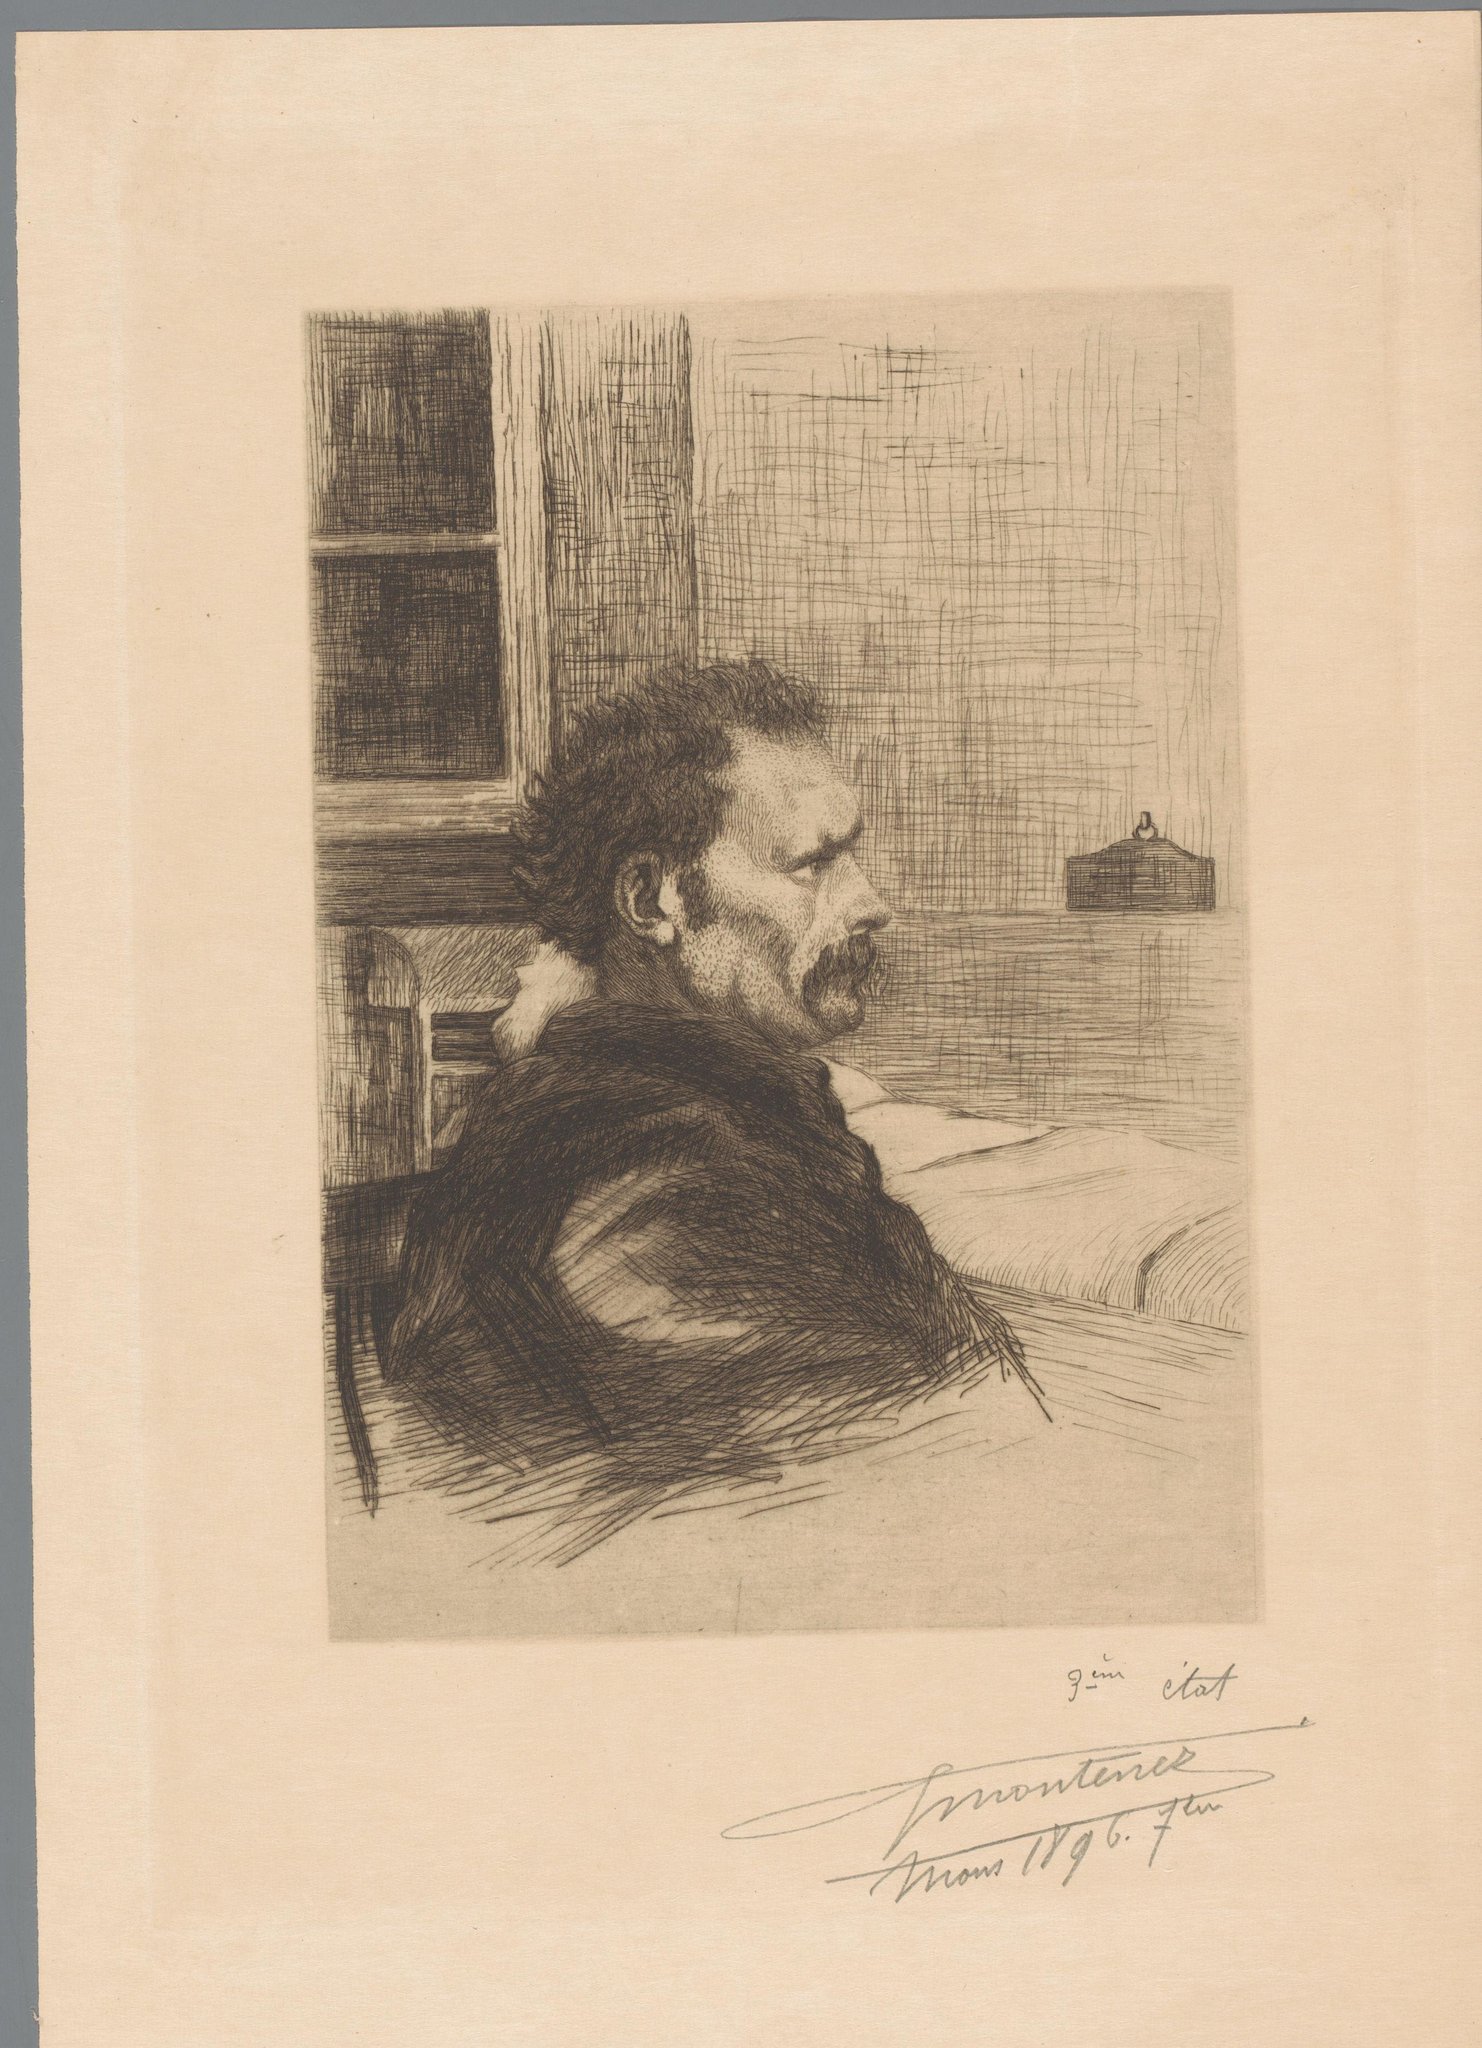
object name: print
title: Portret van een onbekende man in een interieur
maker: georges montenez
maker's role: print maker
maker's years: 1873-1930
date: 1896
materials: paper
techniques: etching, intaglio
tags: adult man, historical persons, interior ~ representation of a building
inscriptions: collector's mark: Lugt 2228, inscription: ‘3em état; Mons 1896 7 em’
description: In de inventaris getiteld: Interieur van een logement in Brussel.